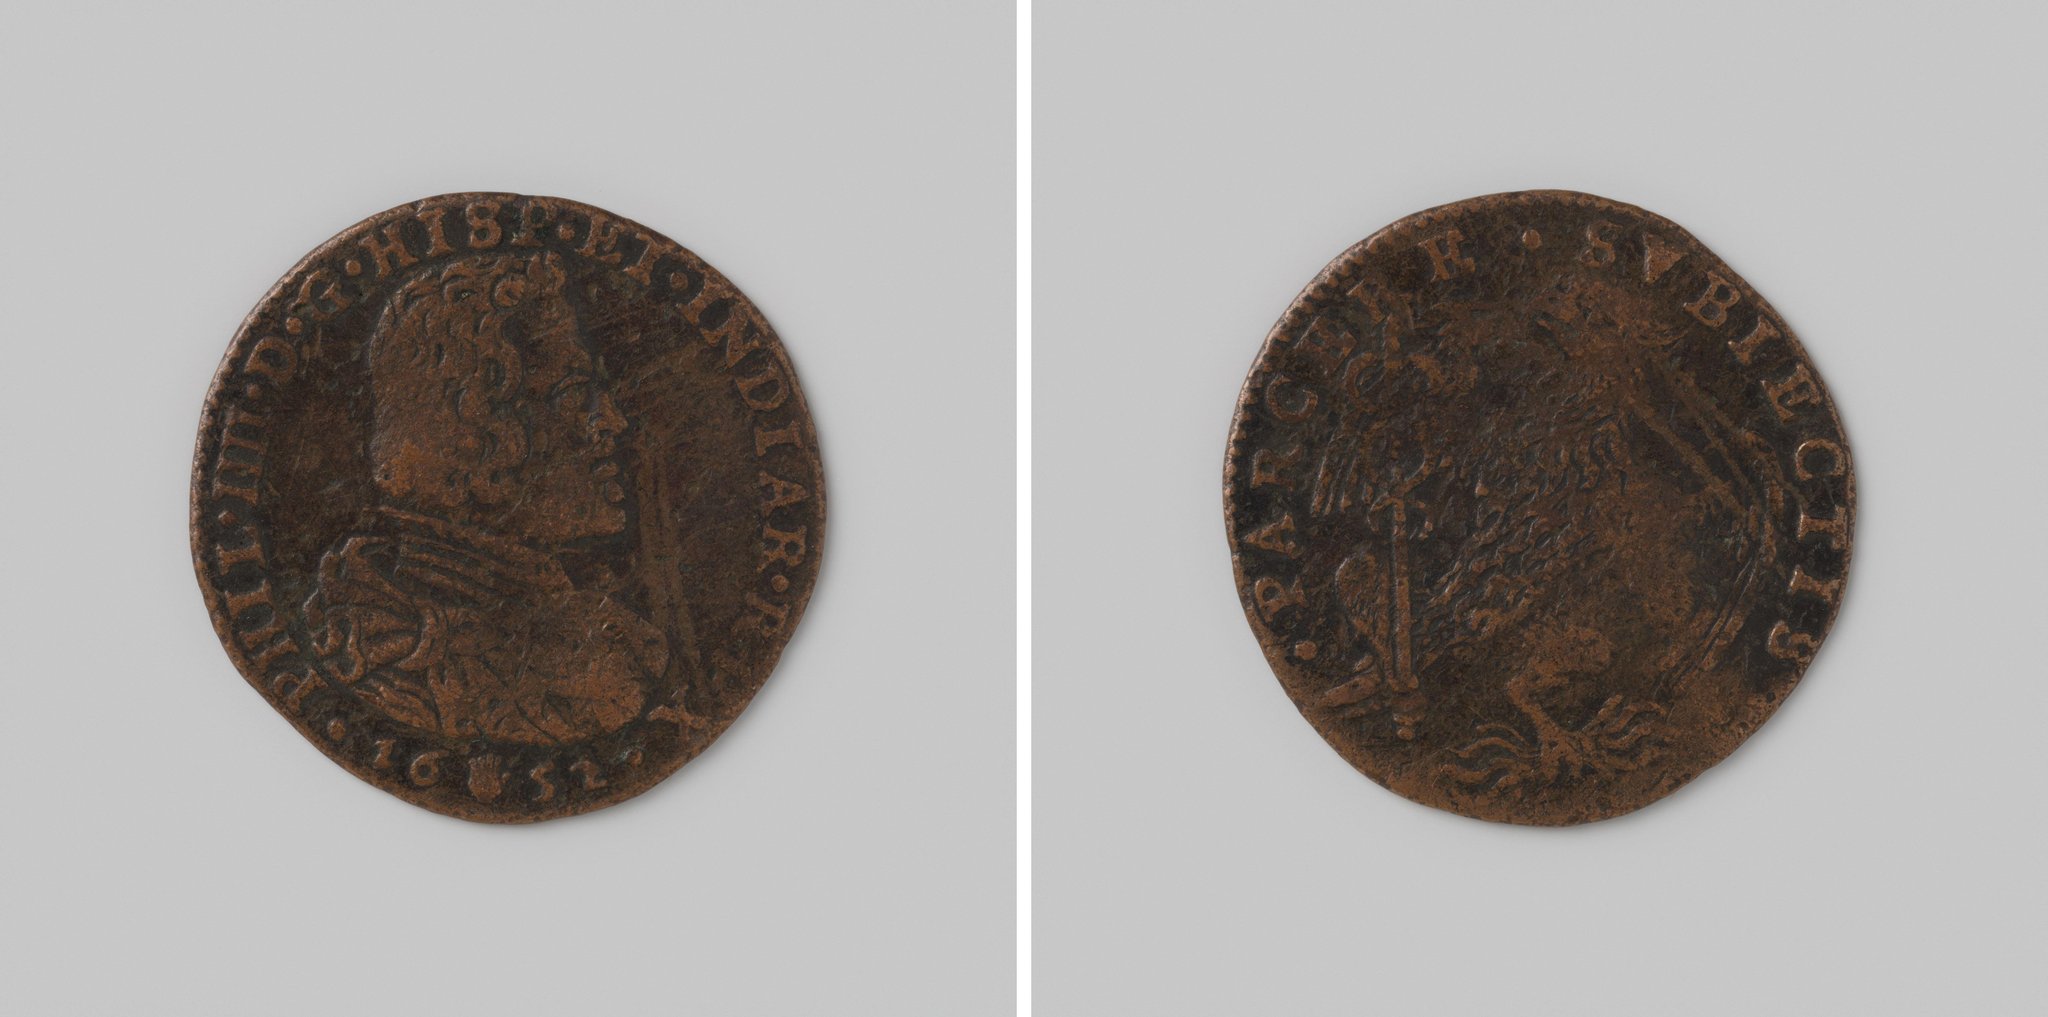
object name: history medal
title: Rekenpenning uit Antwerpen op de Spaanse hulp tegen Kardinaal Mazarin 1652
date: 1652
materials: copper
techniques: striking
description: Koperen penning, op de voozijde het borstbeeld van Philips IV naar rechts met omschrift, op de keerzijde een adelaar met mercuriusstaf en bliksem, met omschrift.